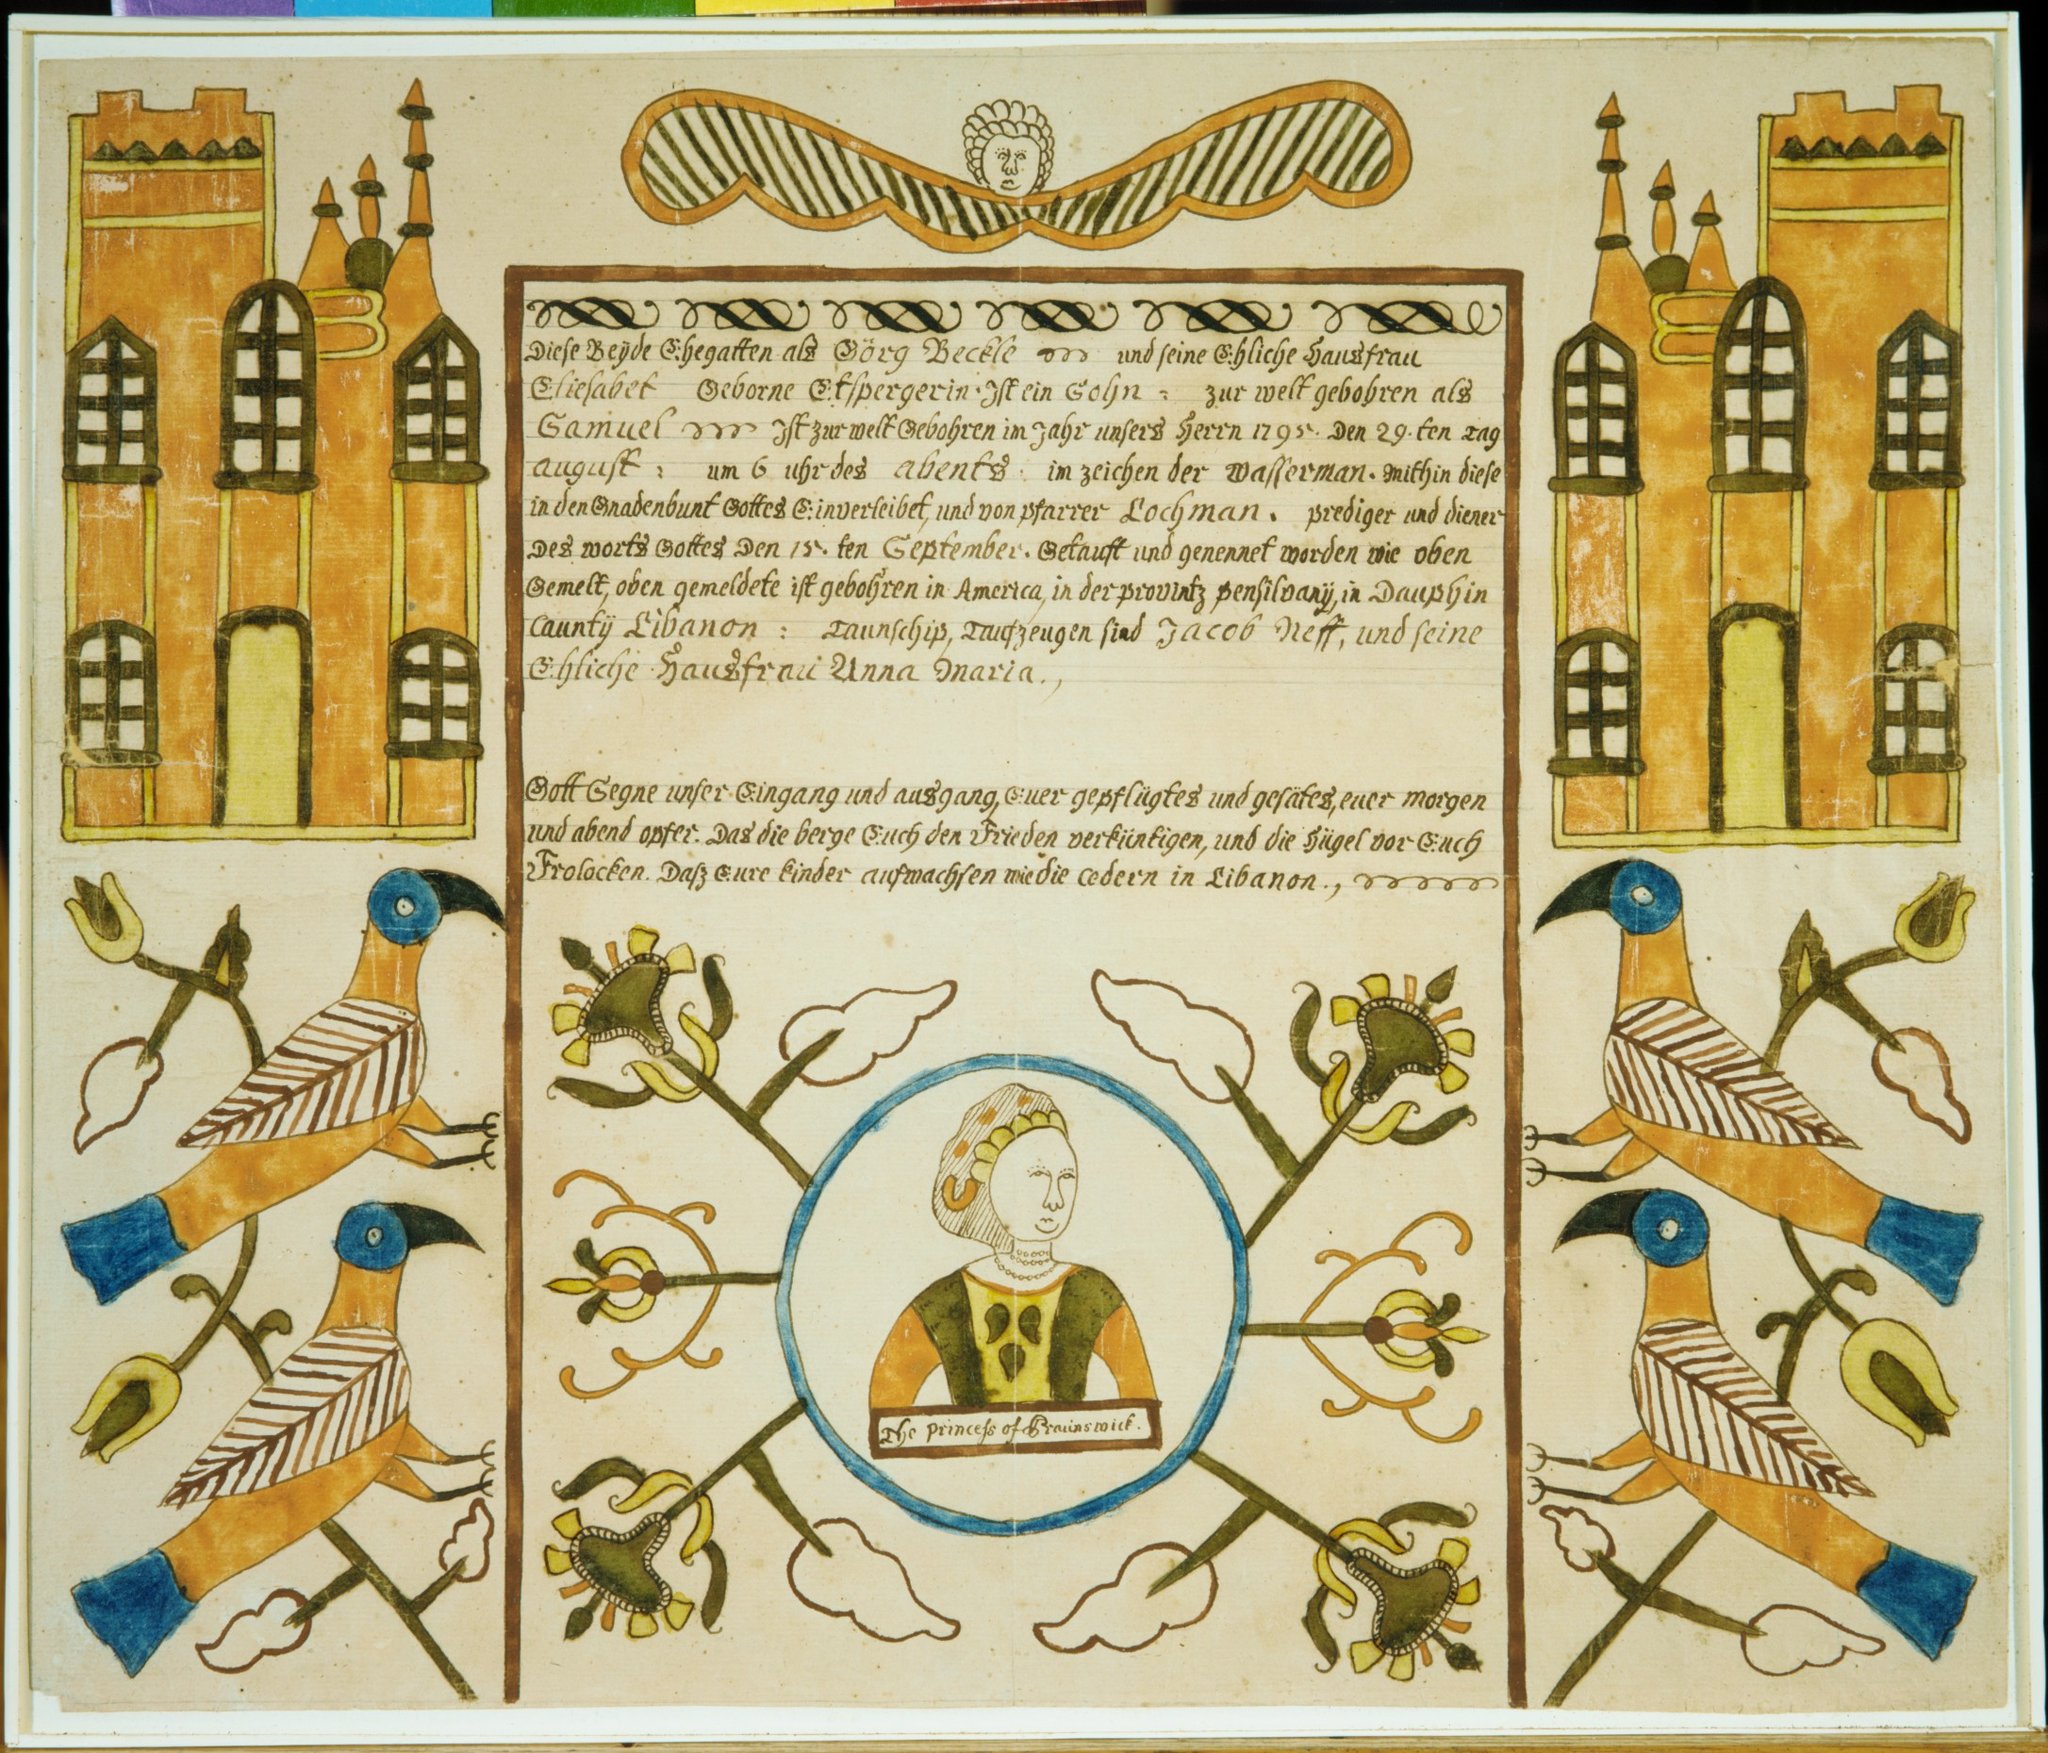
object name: birth and baptismal certificate, fraktur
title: Birth and Baptismal Certificate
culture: american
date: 1795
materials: ink, iron, paper, watercolor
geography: united states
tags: birds,women